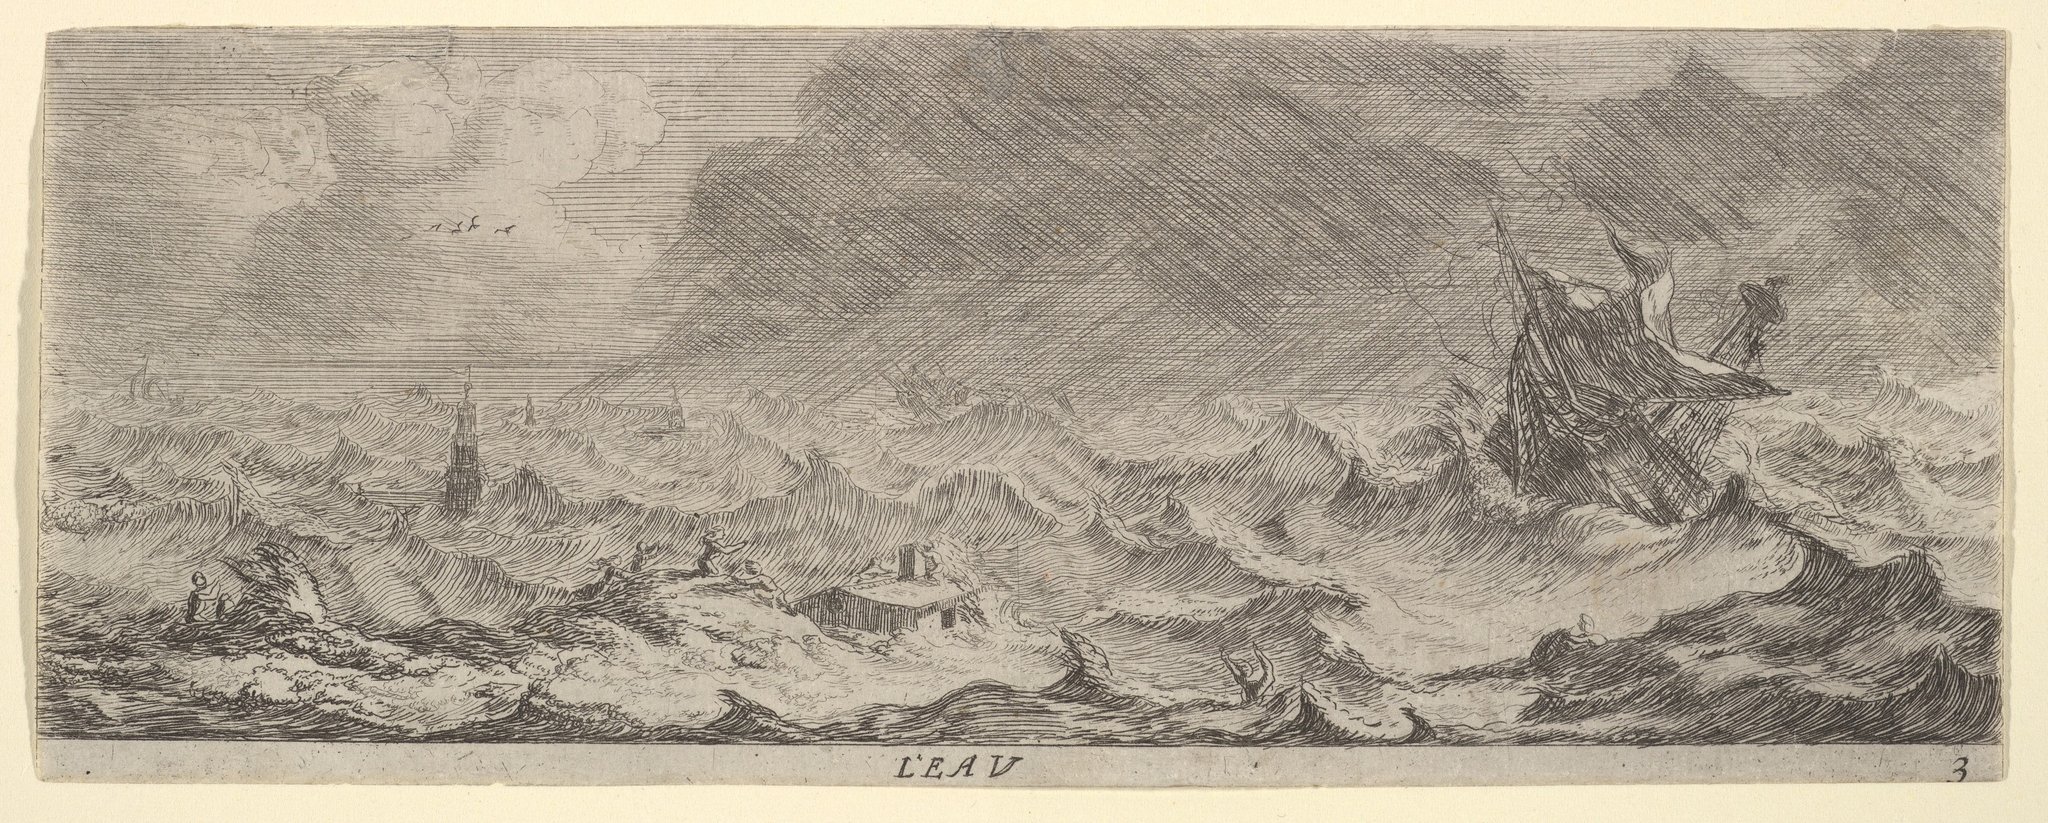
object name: print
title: L'Eau, from The Elements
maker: reinier nooms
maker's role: artist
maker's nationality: dutch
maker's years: 1623-1664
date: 1601-1700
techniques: etching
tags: floods,waves